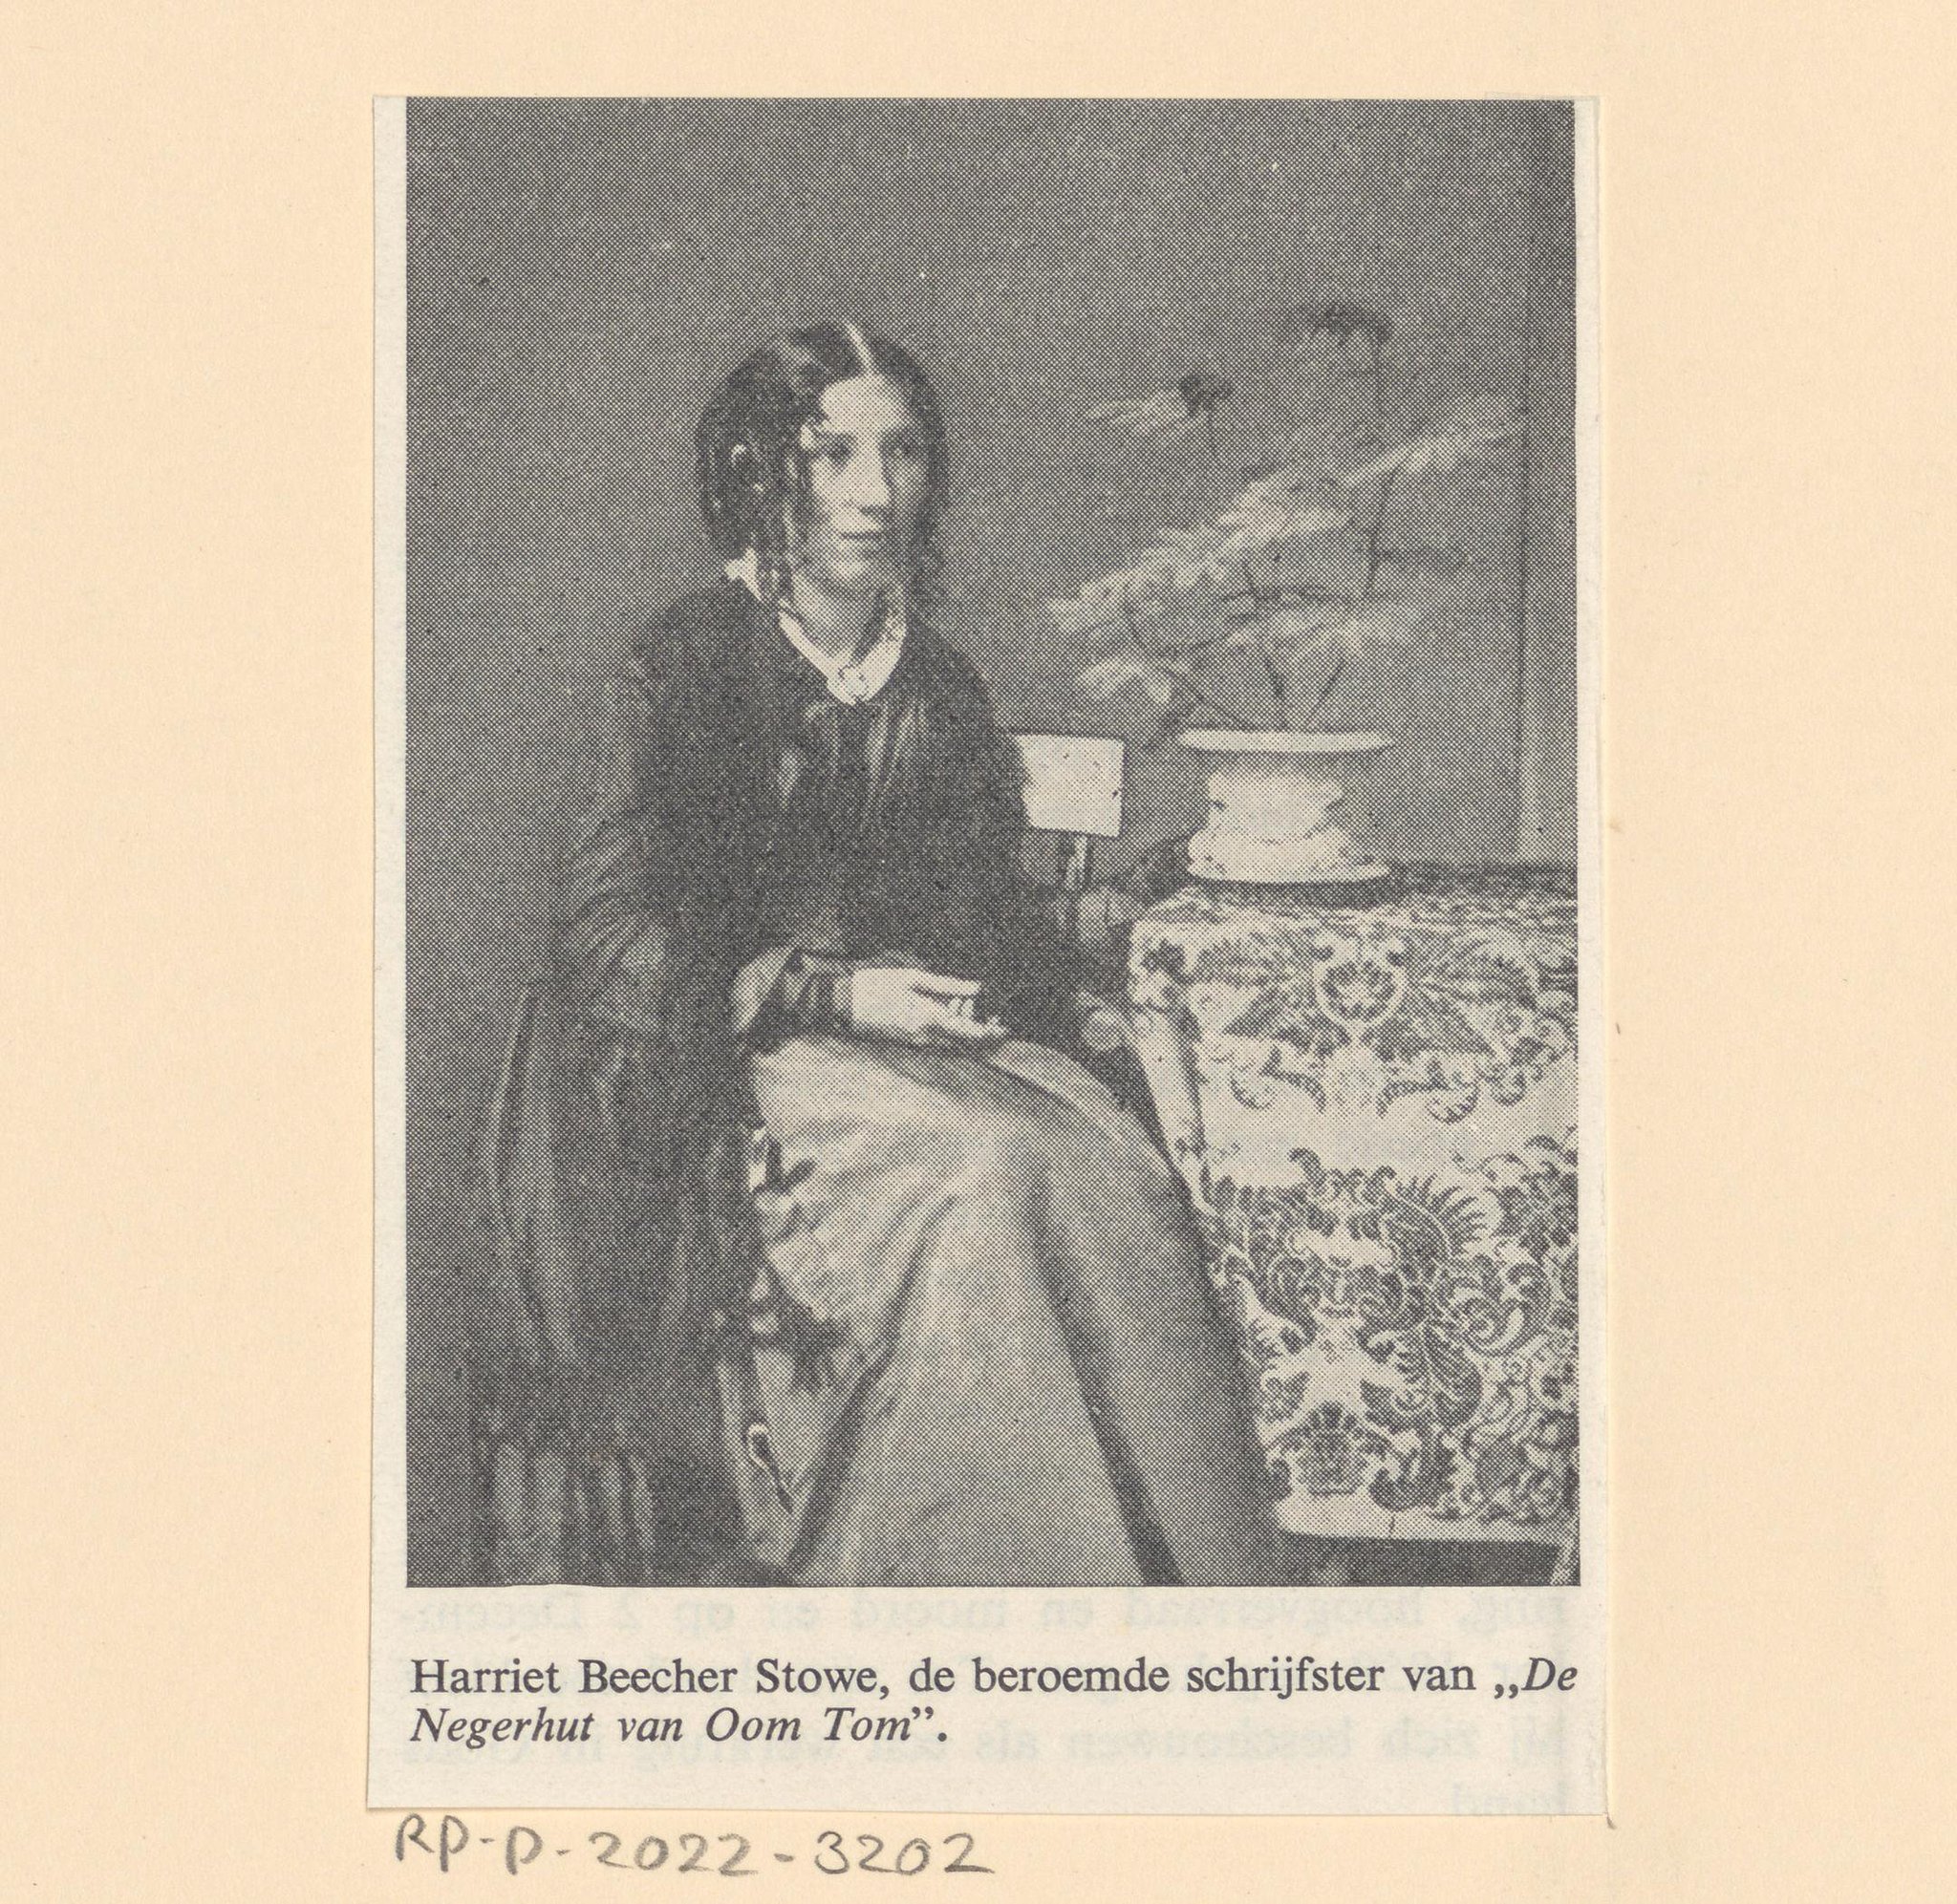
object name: photomechanical print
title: Portret van Harriet Beecher Stowe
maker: Anonymous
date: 1882-1970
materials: paper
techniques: letterpress printing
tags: historical persons - bb - woman, portrait of a writer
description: Met tweeregelig onderschrift in het Nederlands.